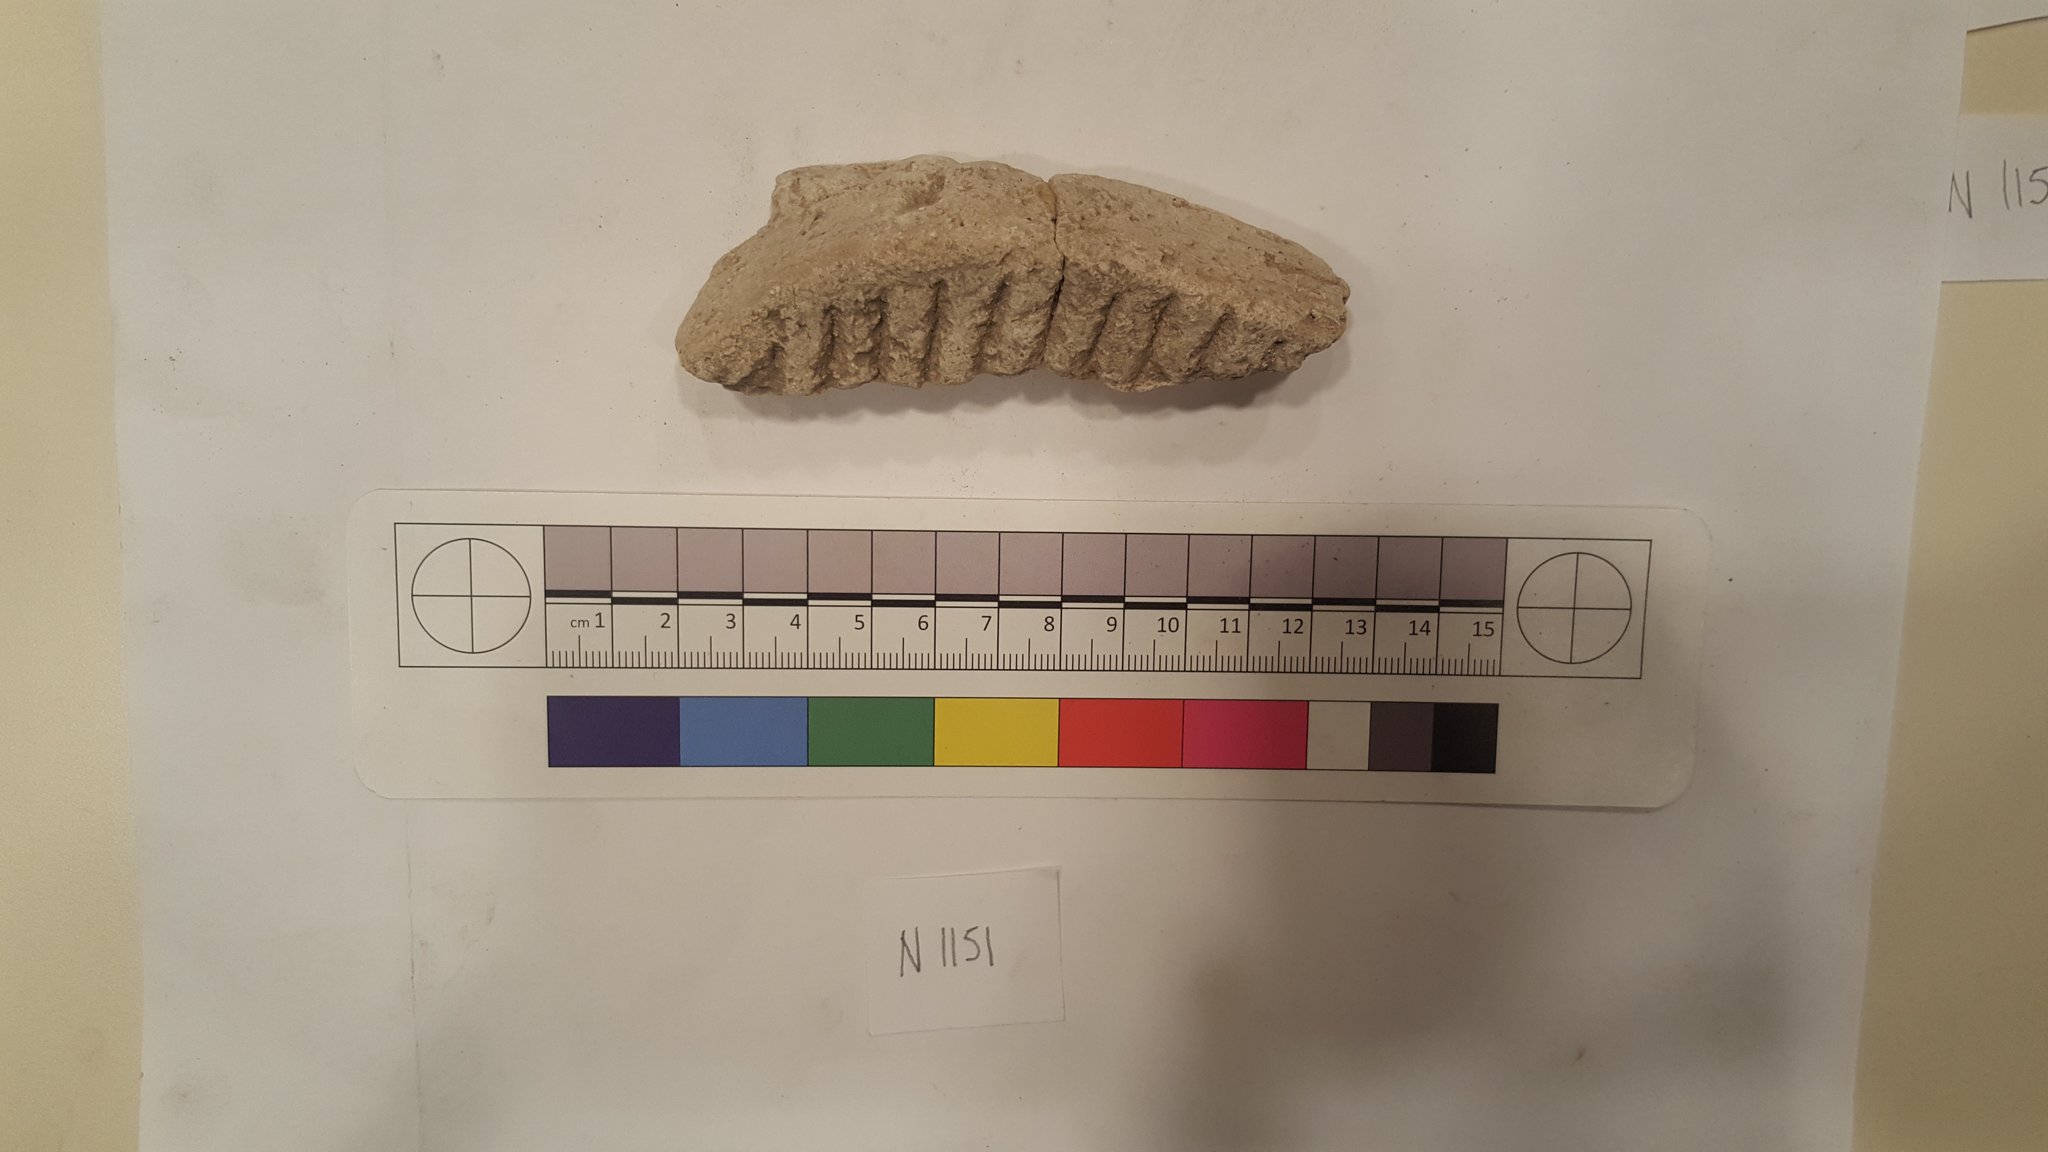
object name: fragment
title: Stucco Fragment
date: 701-1200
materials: plaster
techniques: carving, painting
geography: iran